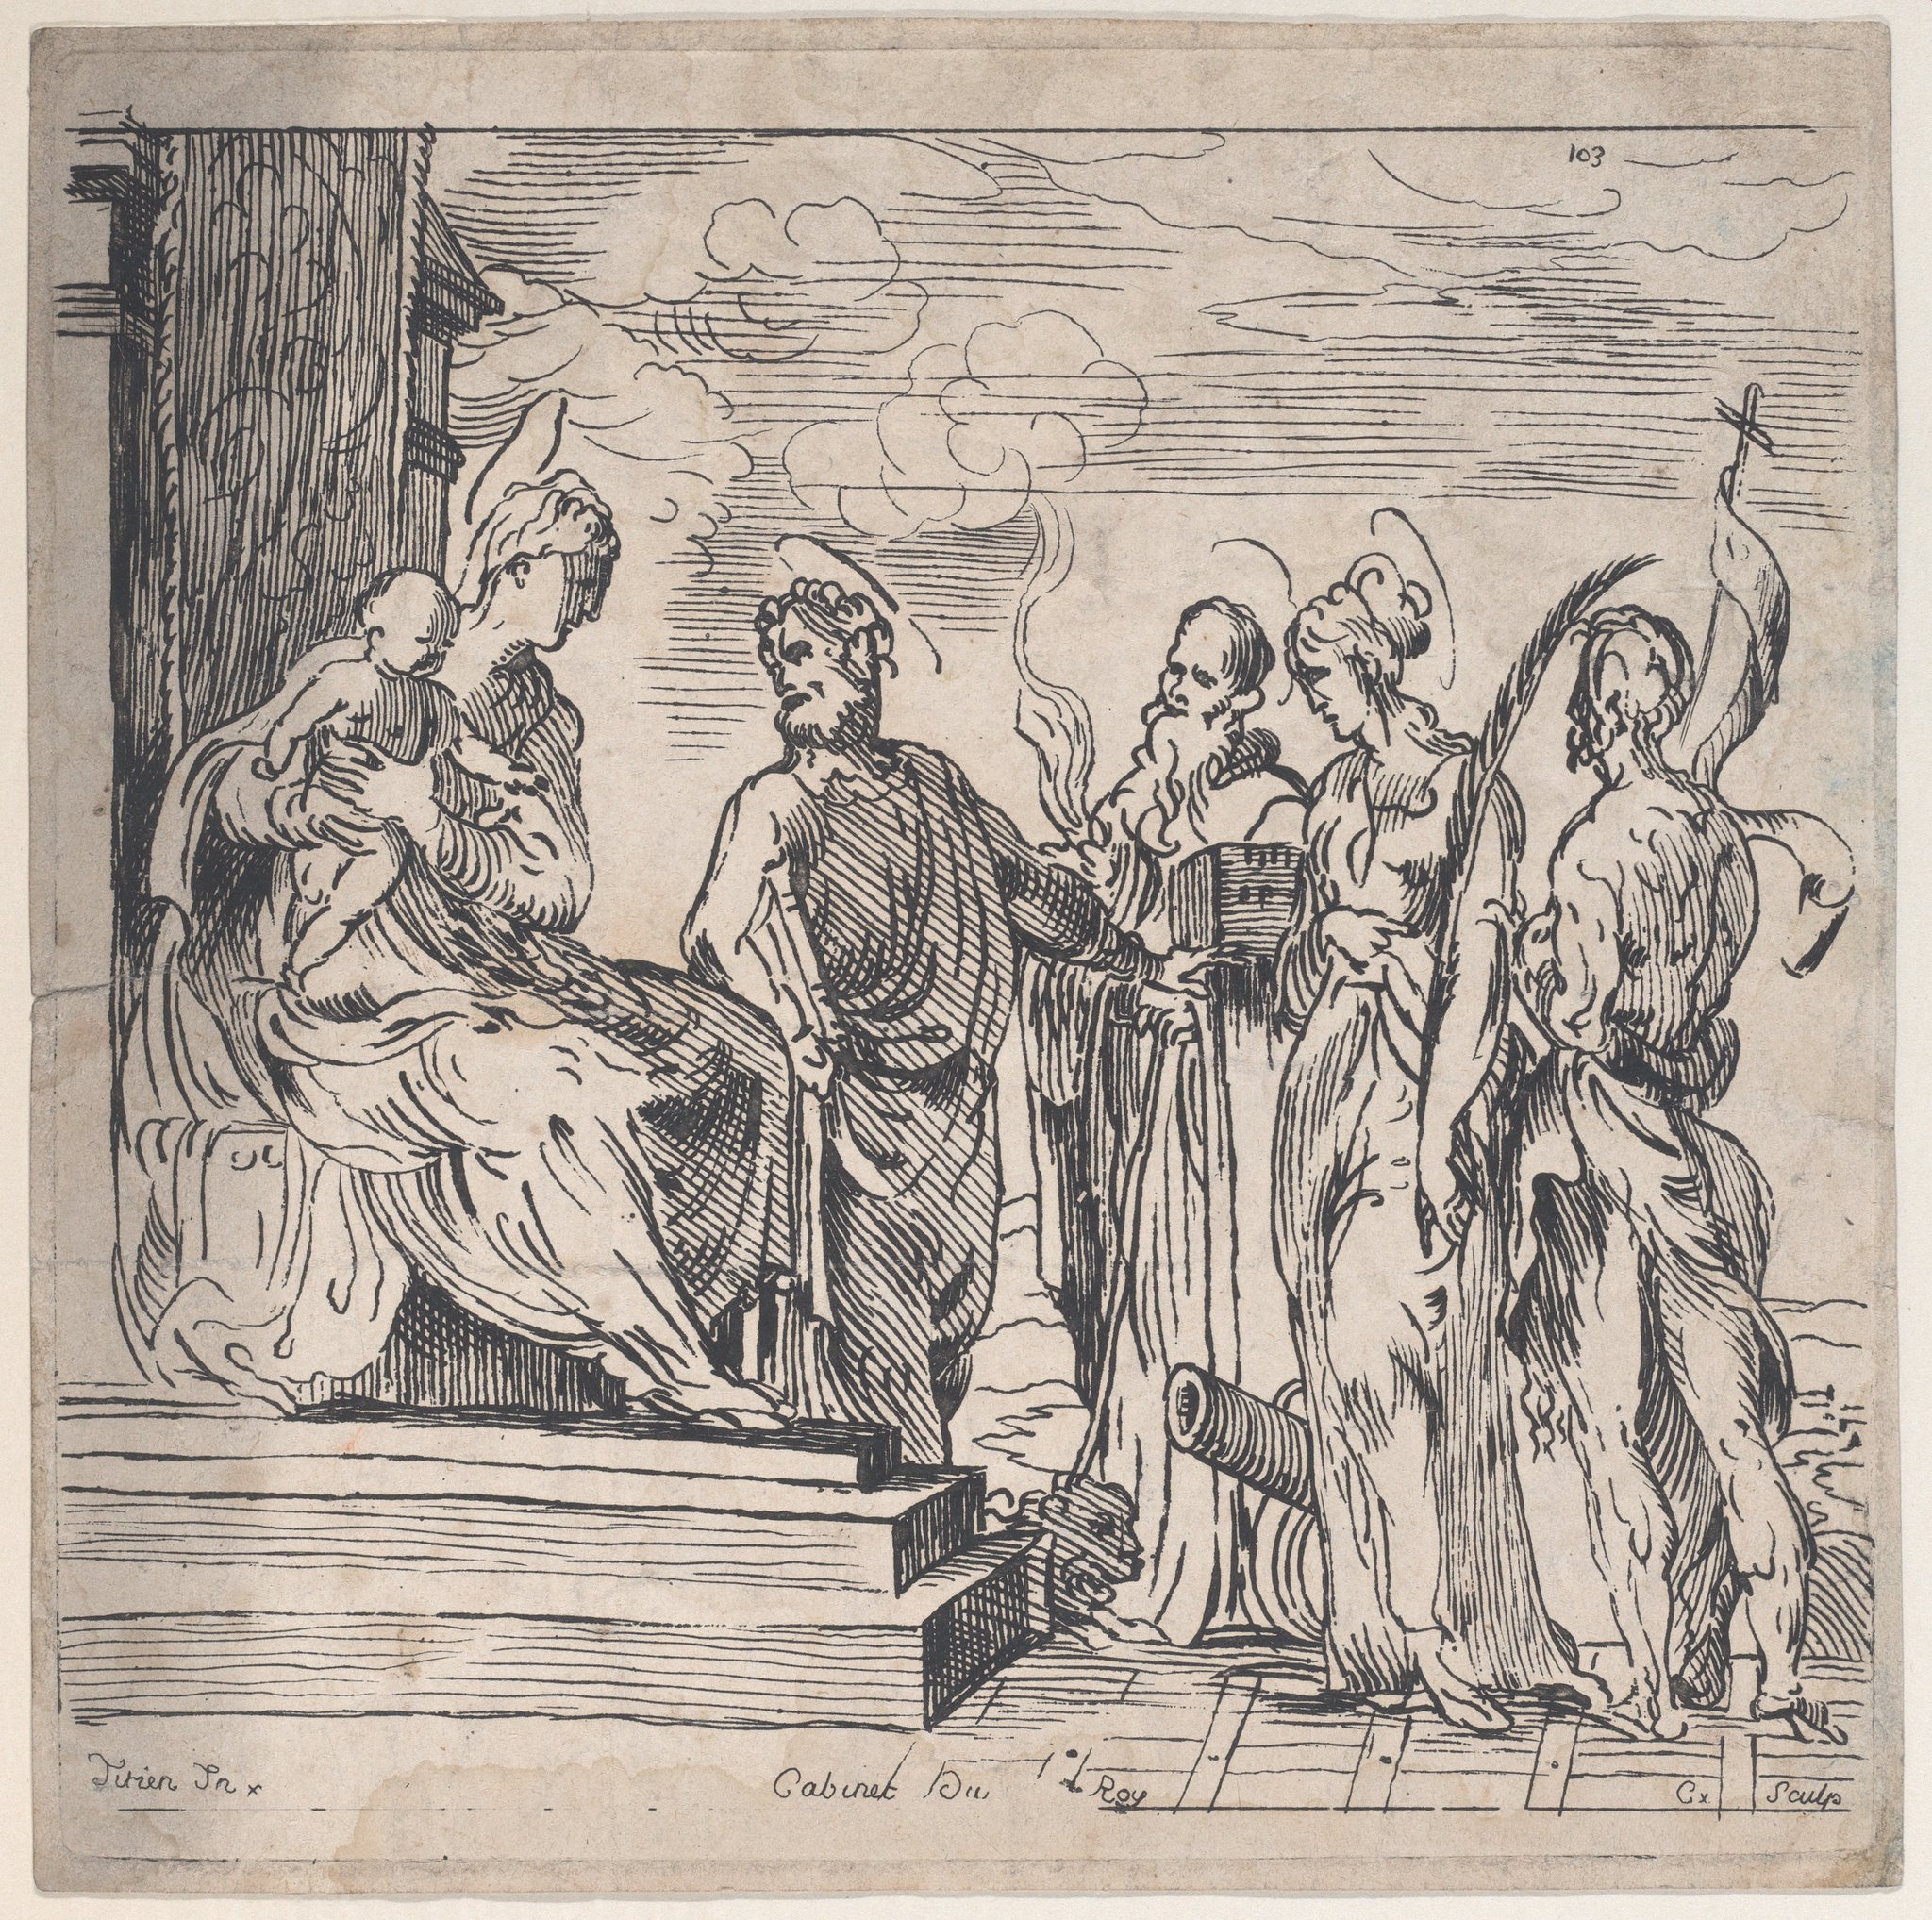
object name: print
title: Virgin and Child with Four Saints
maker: anne claude philippe de tubières, comte de caylus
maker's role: artist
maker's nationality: french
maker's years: 1692-1765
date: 1701-1800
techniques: etching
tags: madonna and child,saints